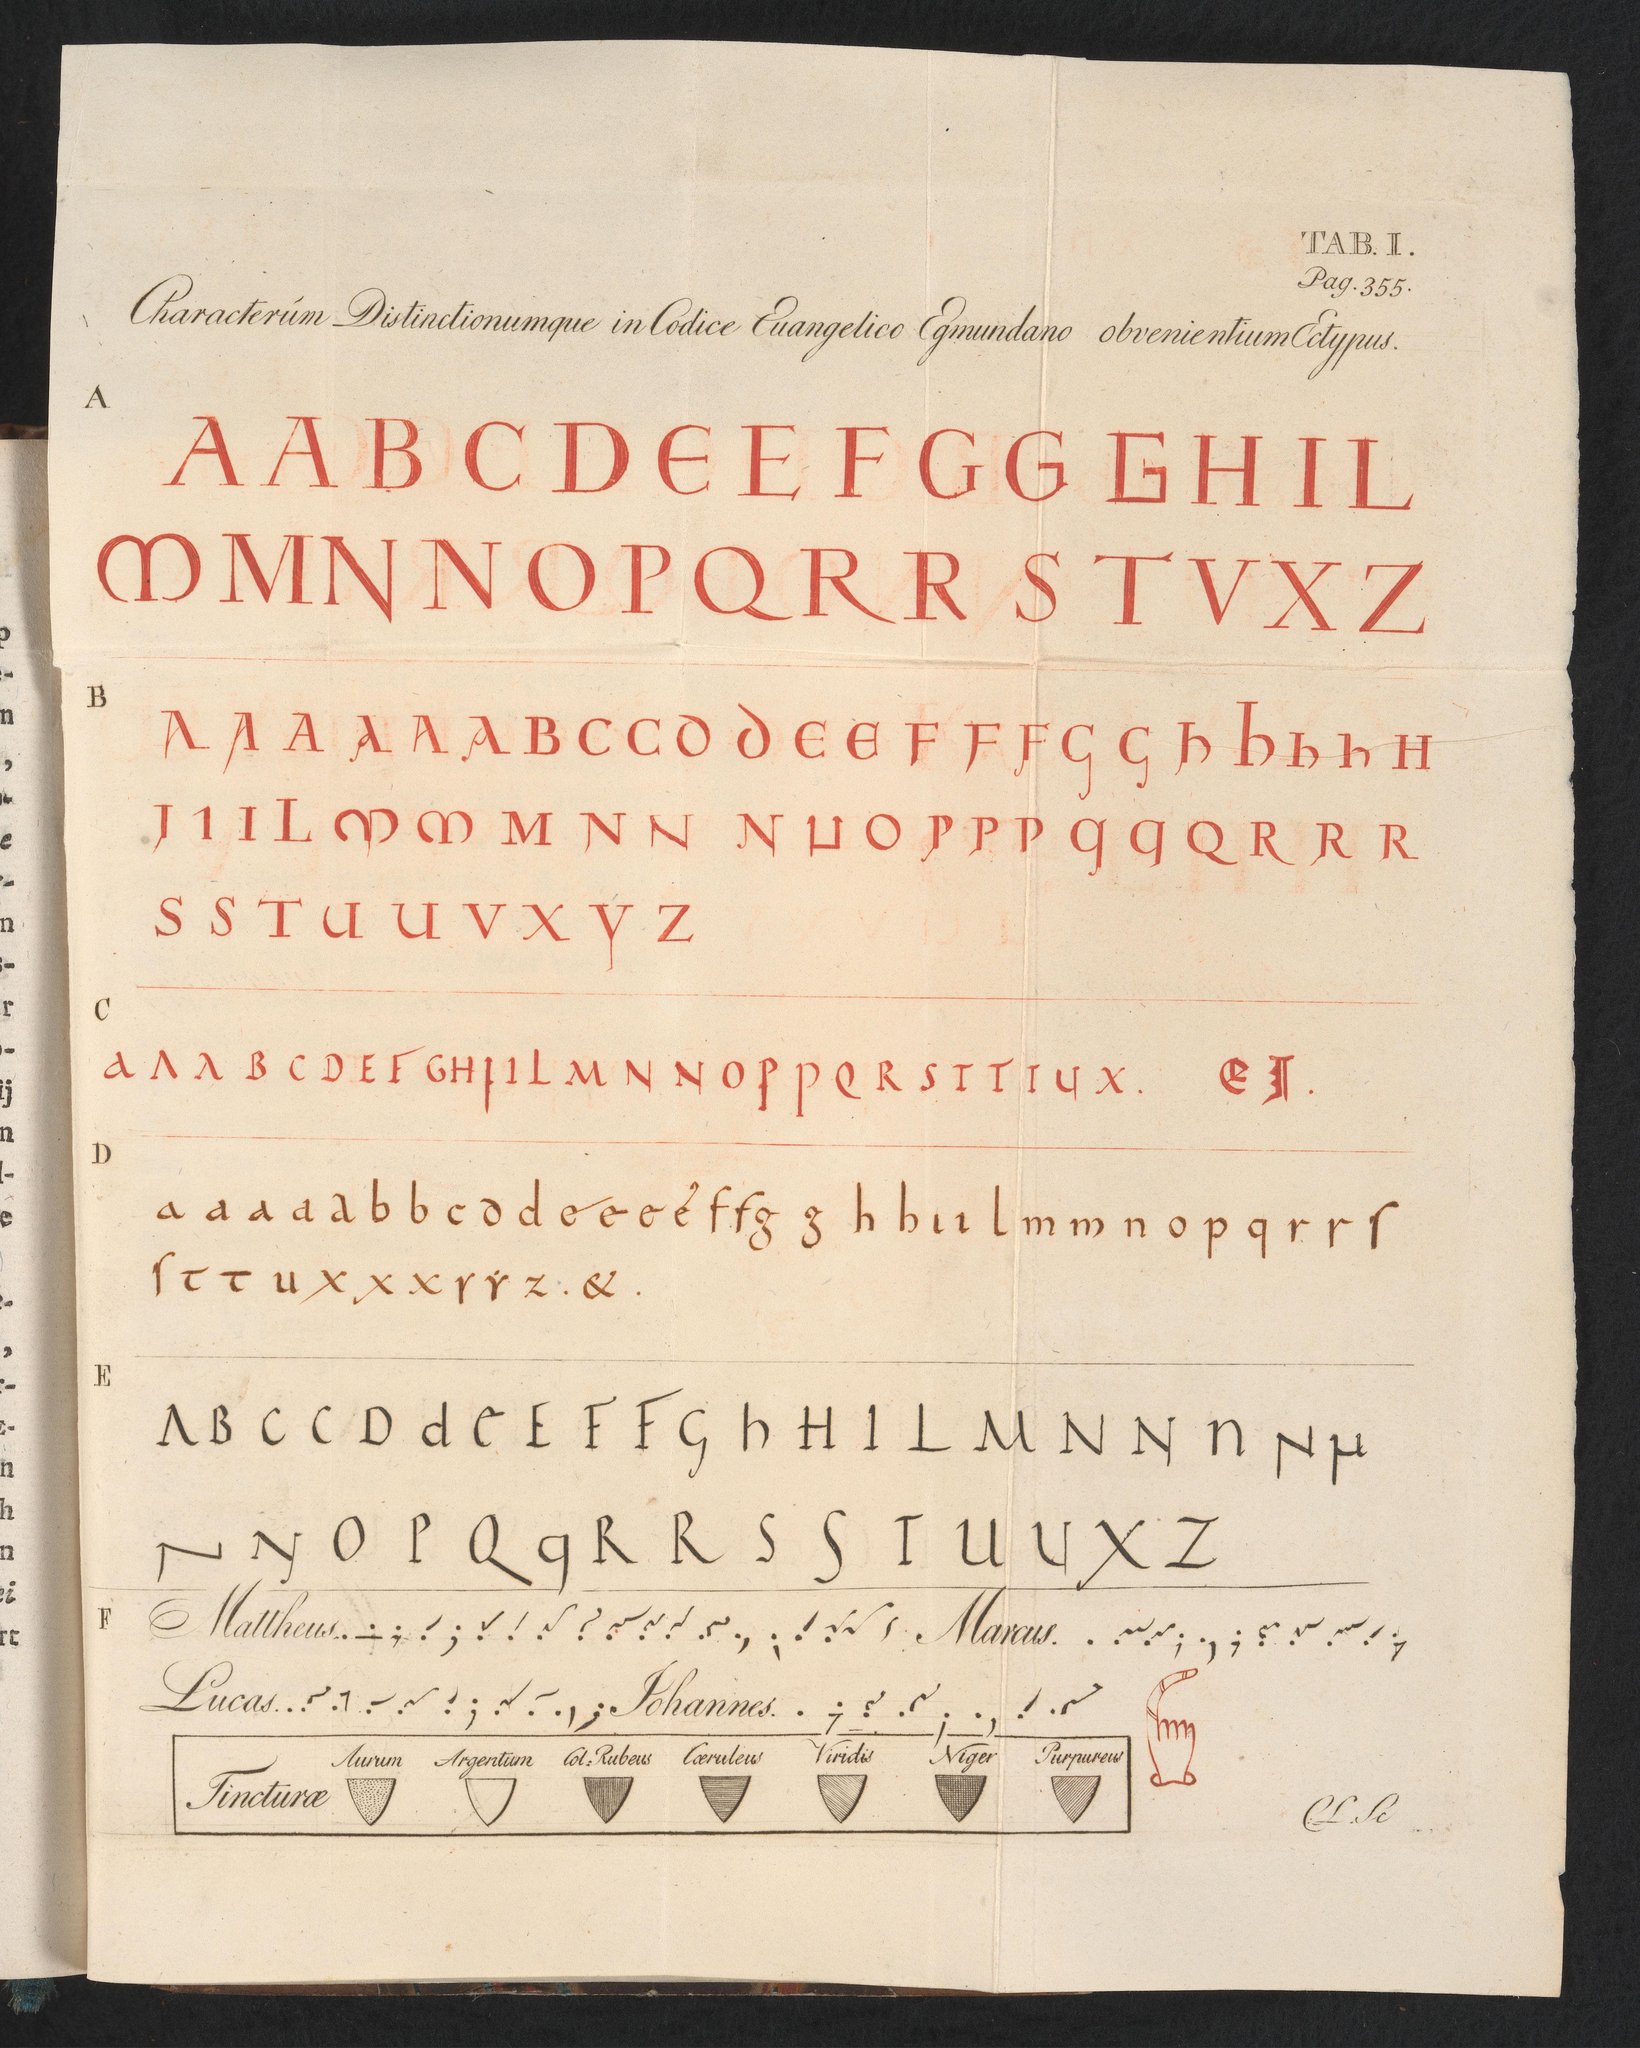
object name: print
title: Voorbeelden van schrift in het Handschrift der Vier Evangelien uit de 10e eeuw, afkomstig uit de abdij van Egmond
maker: christian anthony lotter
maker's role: print maker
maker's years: 1787-1838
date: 1810-1812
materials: paper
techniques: etching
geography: netherlands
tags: handwriting, written text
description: Illustratie in: H. van Wijn, Huiszittend leeven : bevattende eenige mengelstoffen over onderwerpen betreklijk tot de letter-, historie- en oudheidkunde van Nederland, 2 delen, Johannes Allart, Amsterdam 1801-1812, dl. 2, ingebonden tussen p. 354/355, tab. I.